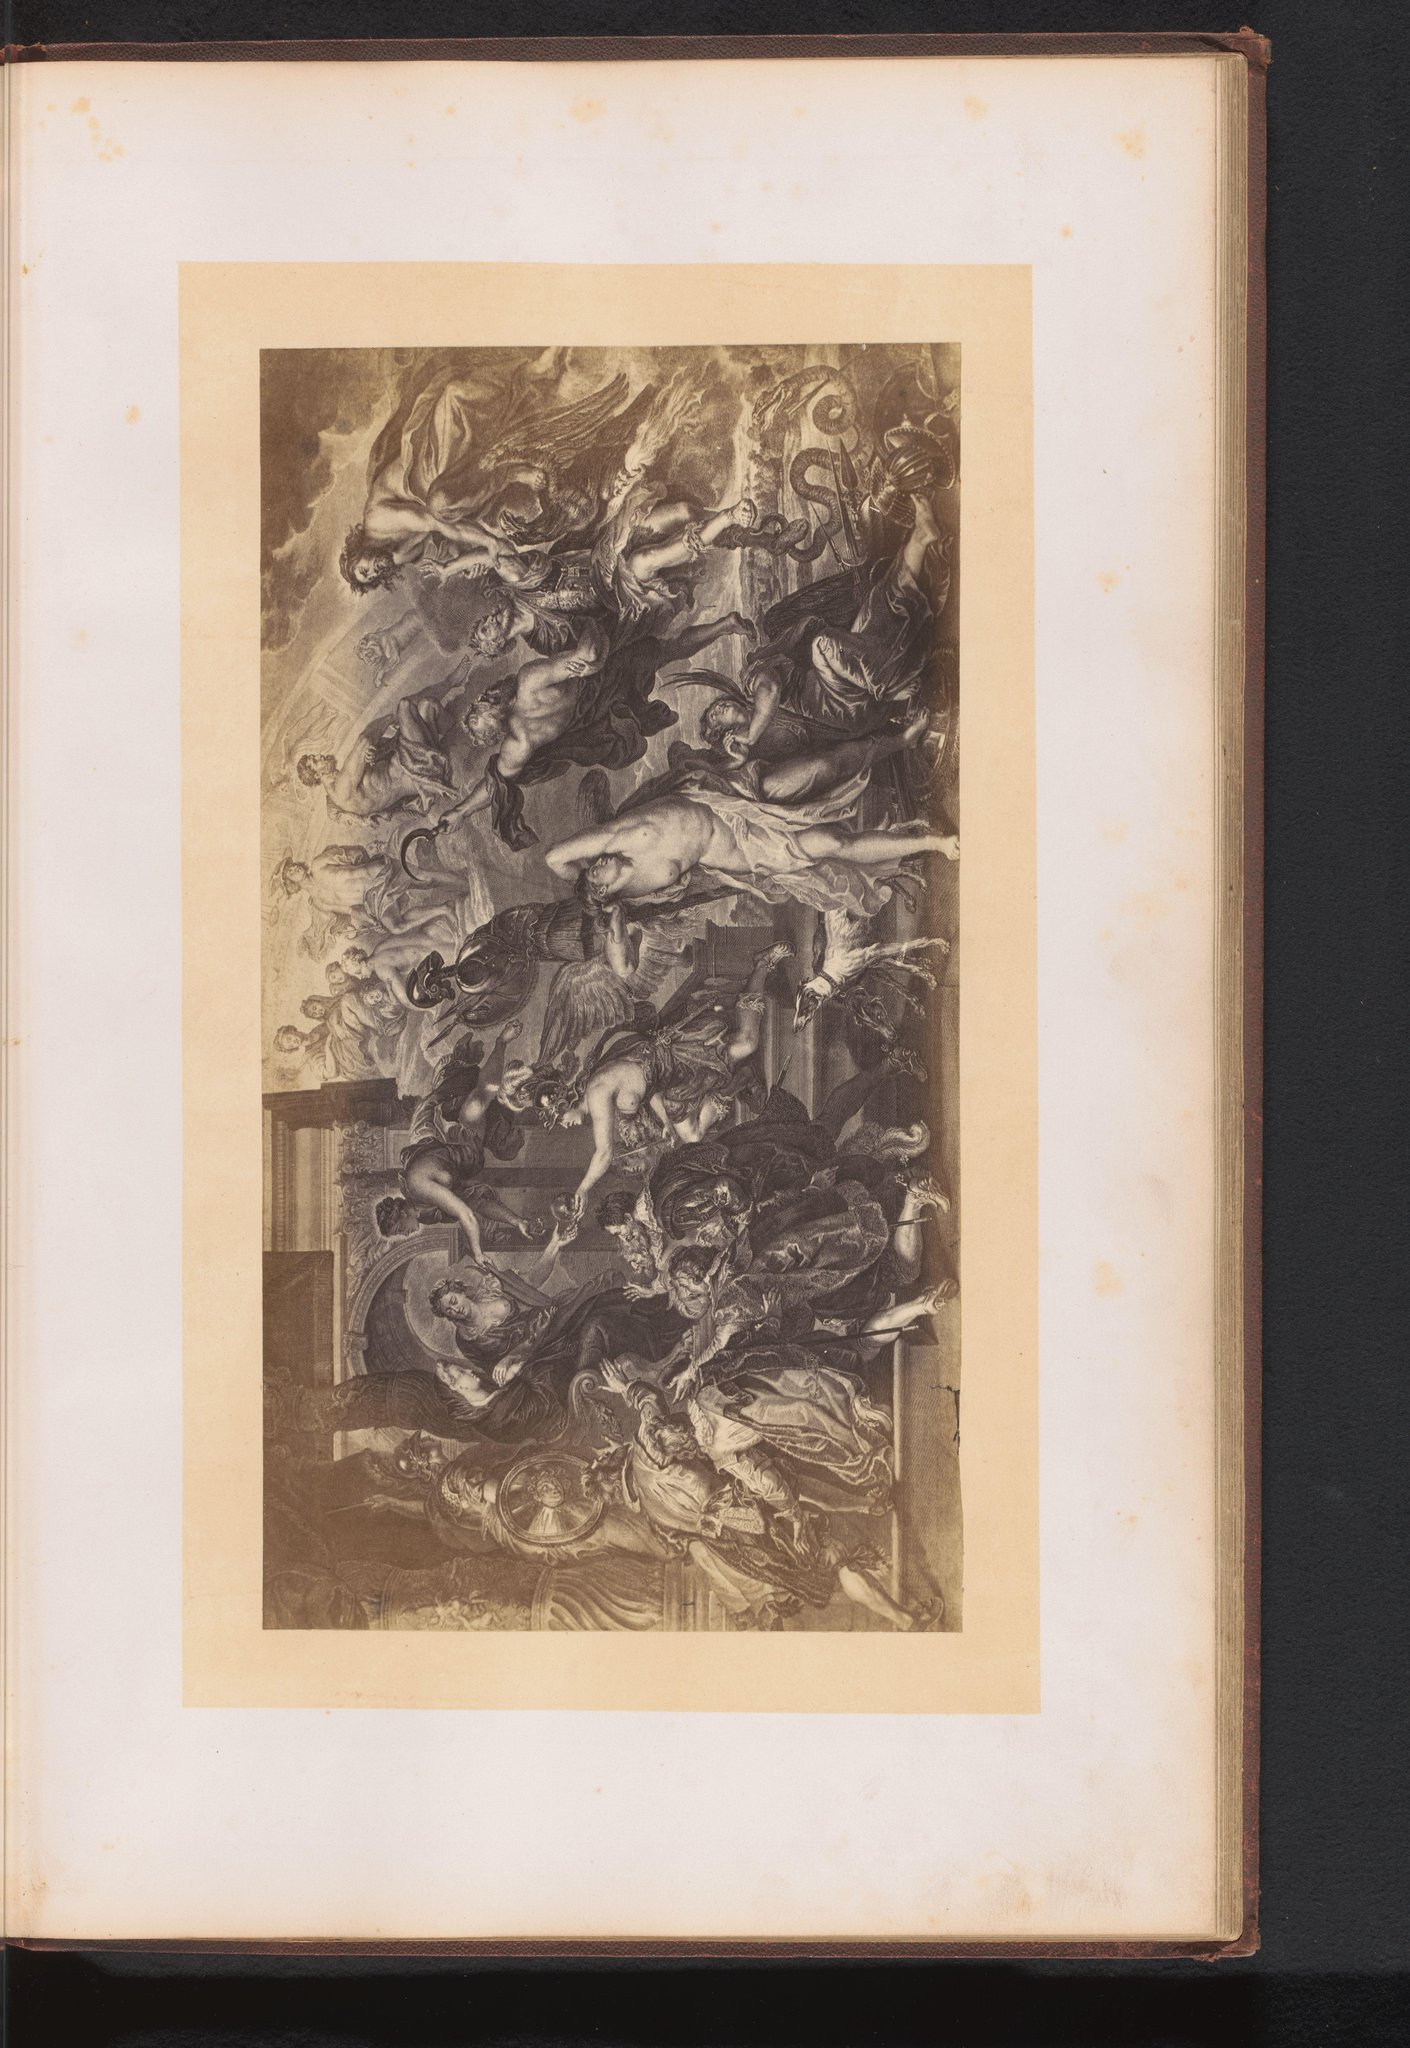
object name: photograph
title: Fotoreproductie van een gravure van Apotheose Hendrik IV en de huldiging van Maria de'Medici door Jean-Marc Nattier, naar het schilderij door Peter Paul Rubens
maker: peter paul rubens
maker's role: draughtsman, painter, print maker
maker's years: 1577-1640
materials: photographic support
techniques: albumen print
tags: cologne, print maker, maria de' medici, paris, hendrik iv (koning van frankrijk en navarra), installation of a ruler - bb - female ruler, apotheosis of a ruler